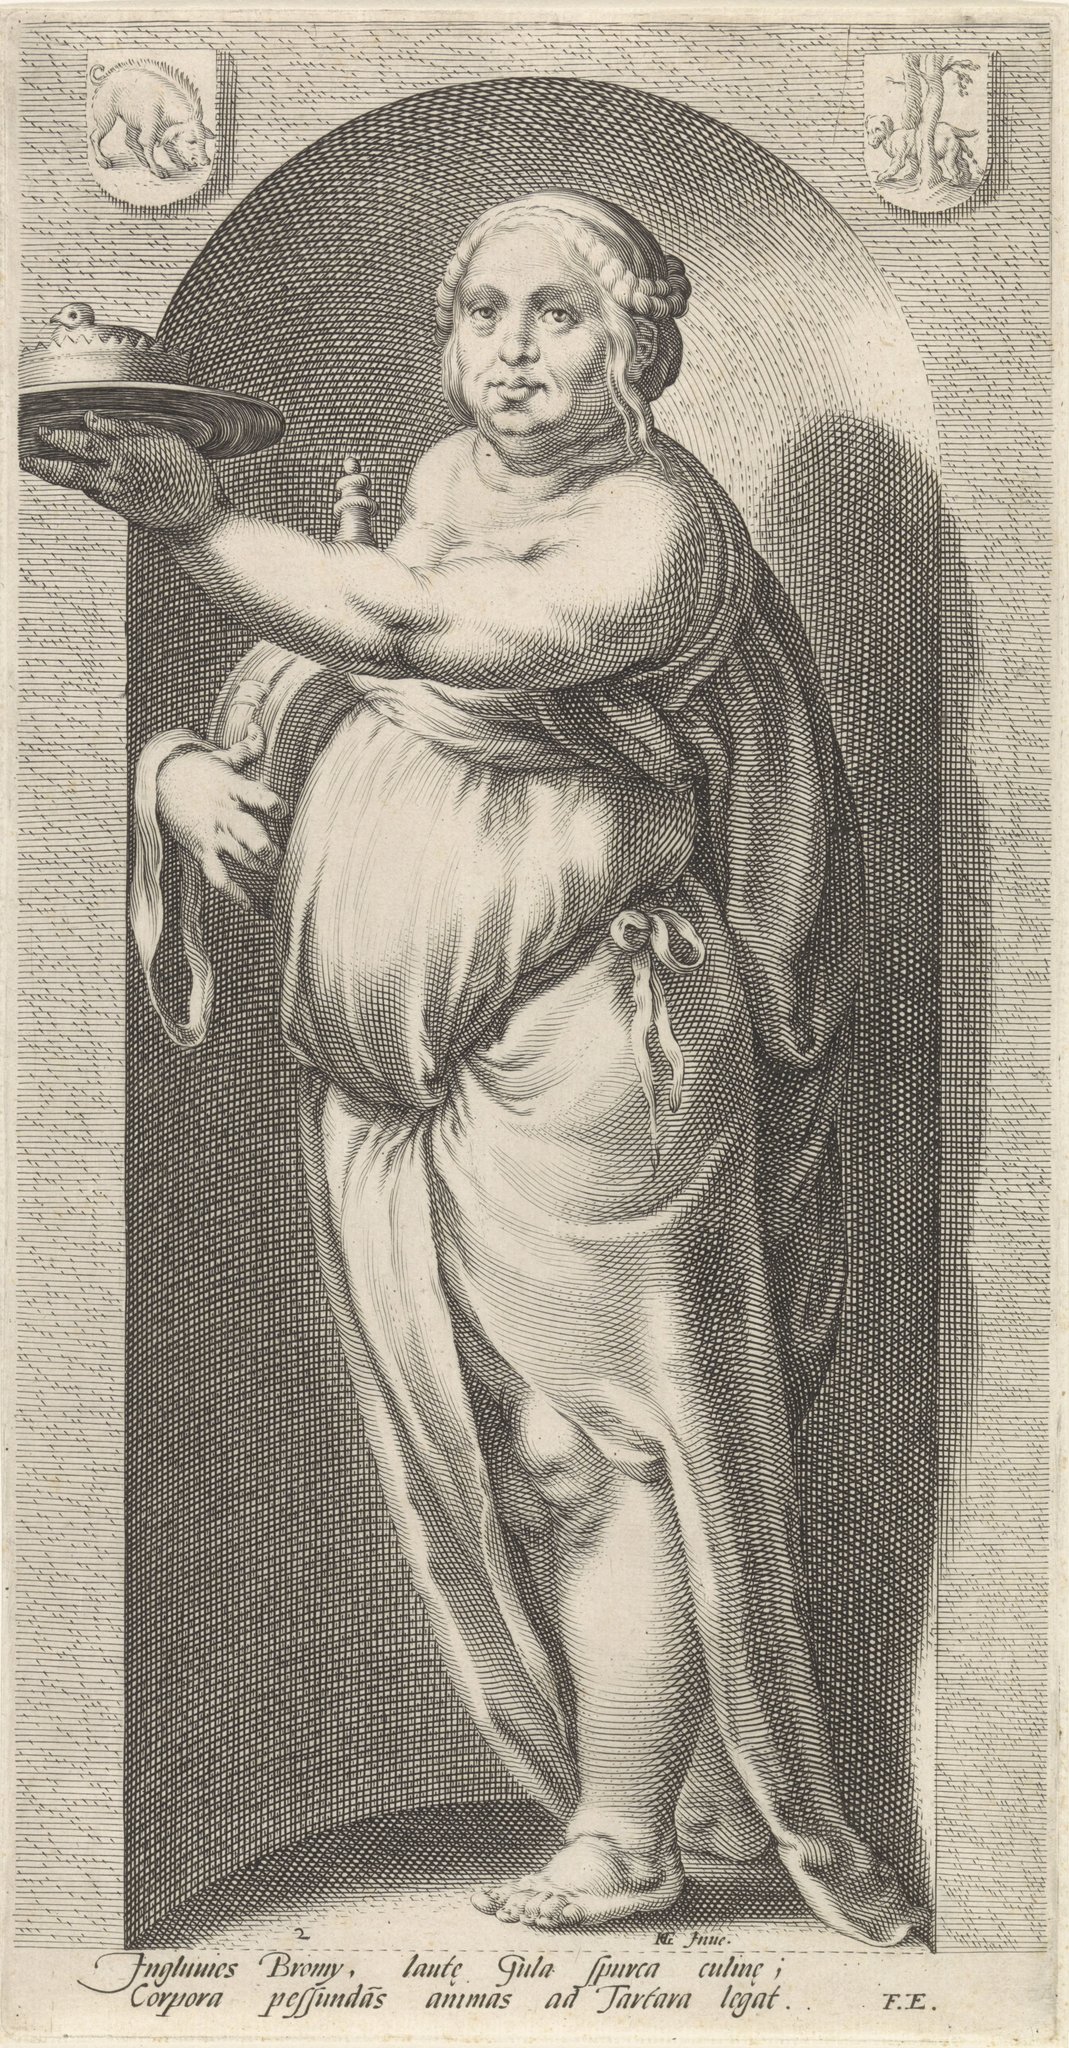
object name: print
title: Gulzigheid (Gula)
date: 1593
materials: paper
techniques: engraving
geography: haarlem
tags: gluttony, intemperance, 'gula'; 'gola', 'ingordigia', 'ingordigia overo avidità', 'voracità' (ripa) ~ personification of one of the seven deadly sins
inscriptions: collector's mark: Lugt 2228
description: Personificatie van gulzigheid, verbeeld als een dik vrouwenfiguur met een pastei, staand in een nis.